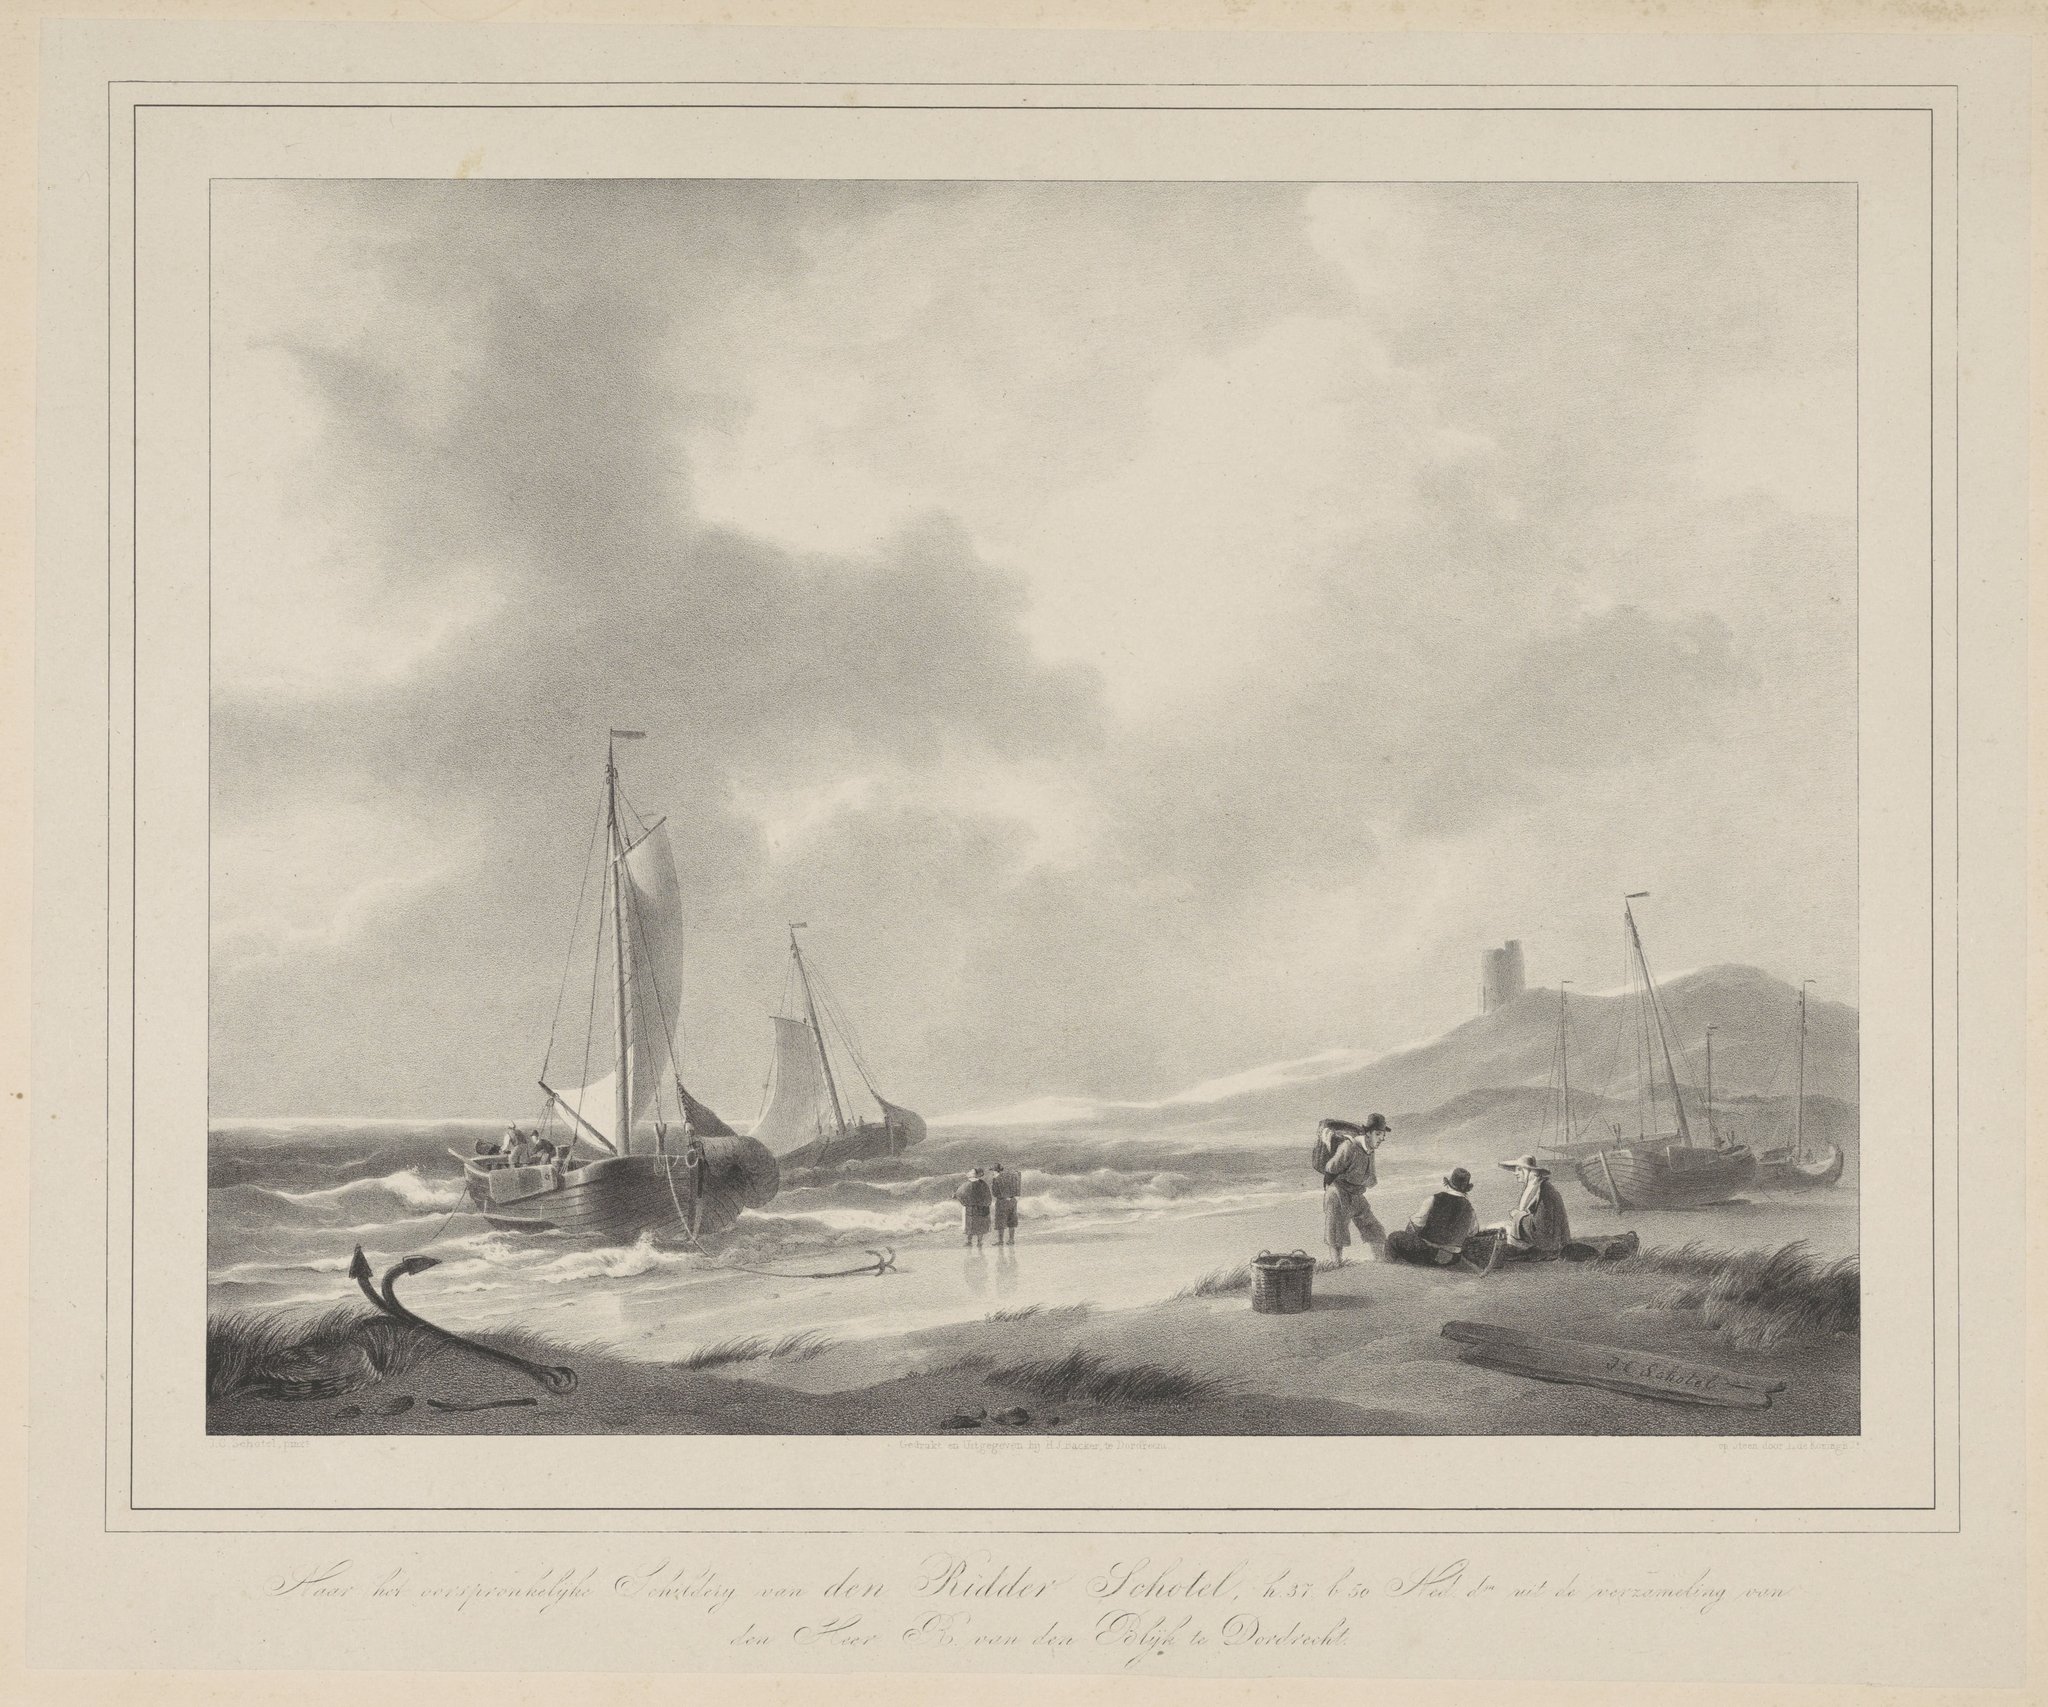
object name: print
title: Strandgezicht met twee zeilboten in de branding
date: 1822-1845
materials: paper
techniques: lithograph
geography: dordrecht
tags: sailing-ship, sailing-boat (+ arrival, coming to anchor, at anchor), sea (seascape), surf, breakers, coast, ships, boats on land, beached, beach (+ landscape with figures, staffage)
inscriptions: collector's mark: Lugt 2760, collector's mark: Lugt 2166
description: Maakt deel uit van een serie prenten naar schilderijen van Johannes Christiaan Schotel uit de collectie van R. van den Blijk uit Dordrecht. Zie RP-P-1939-1511, RP-P-OB-28.940, RP-P-1906-3840, RP-P-1906-3838, RP-P-1906-3839 en RP-P-1906-3837.